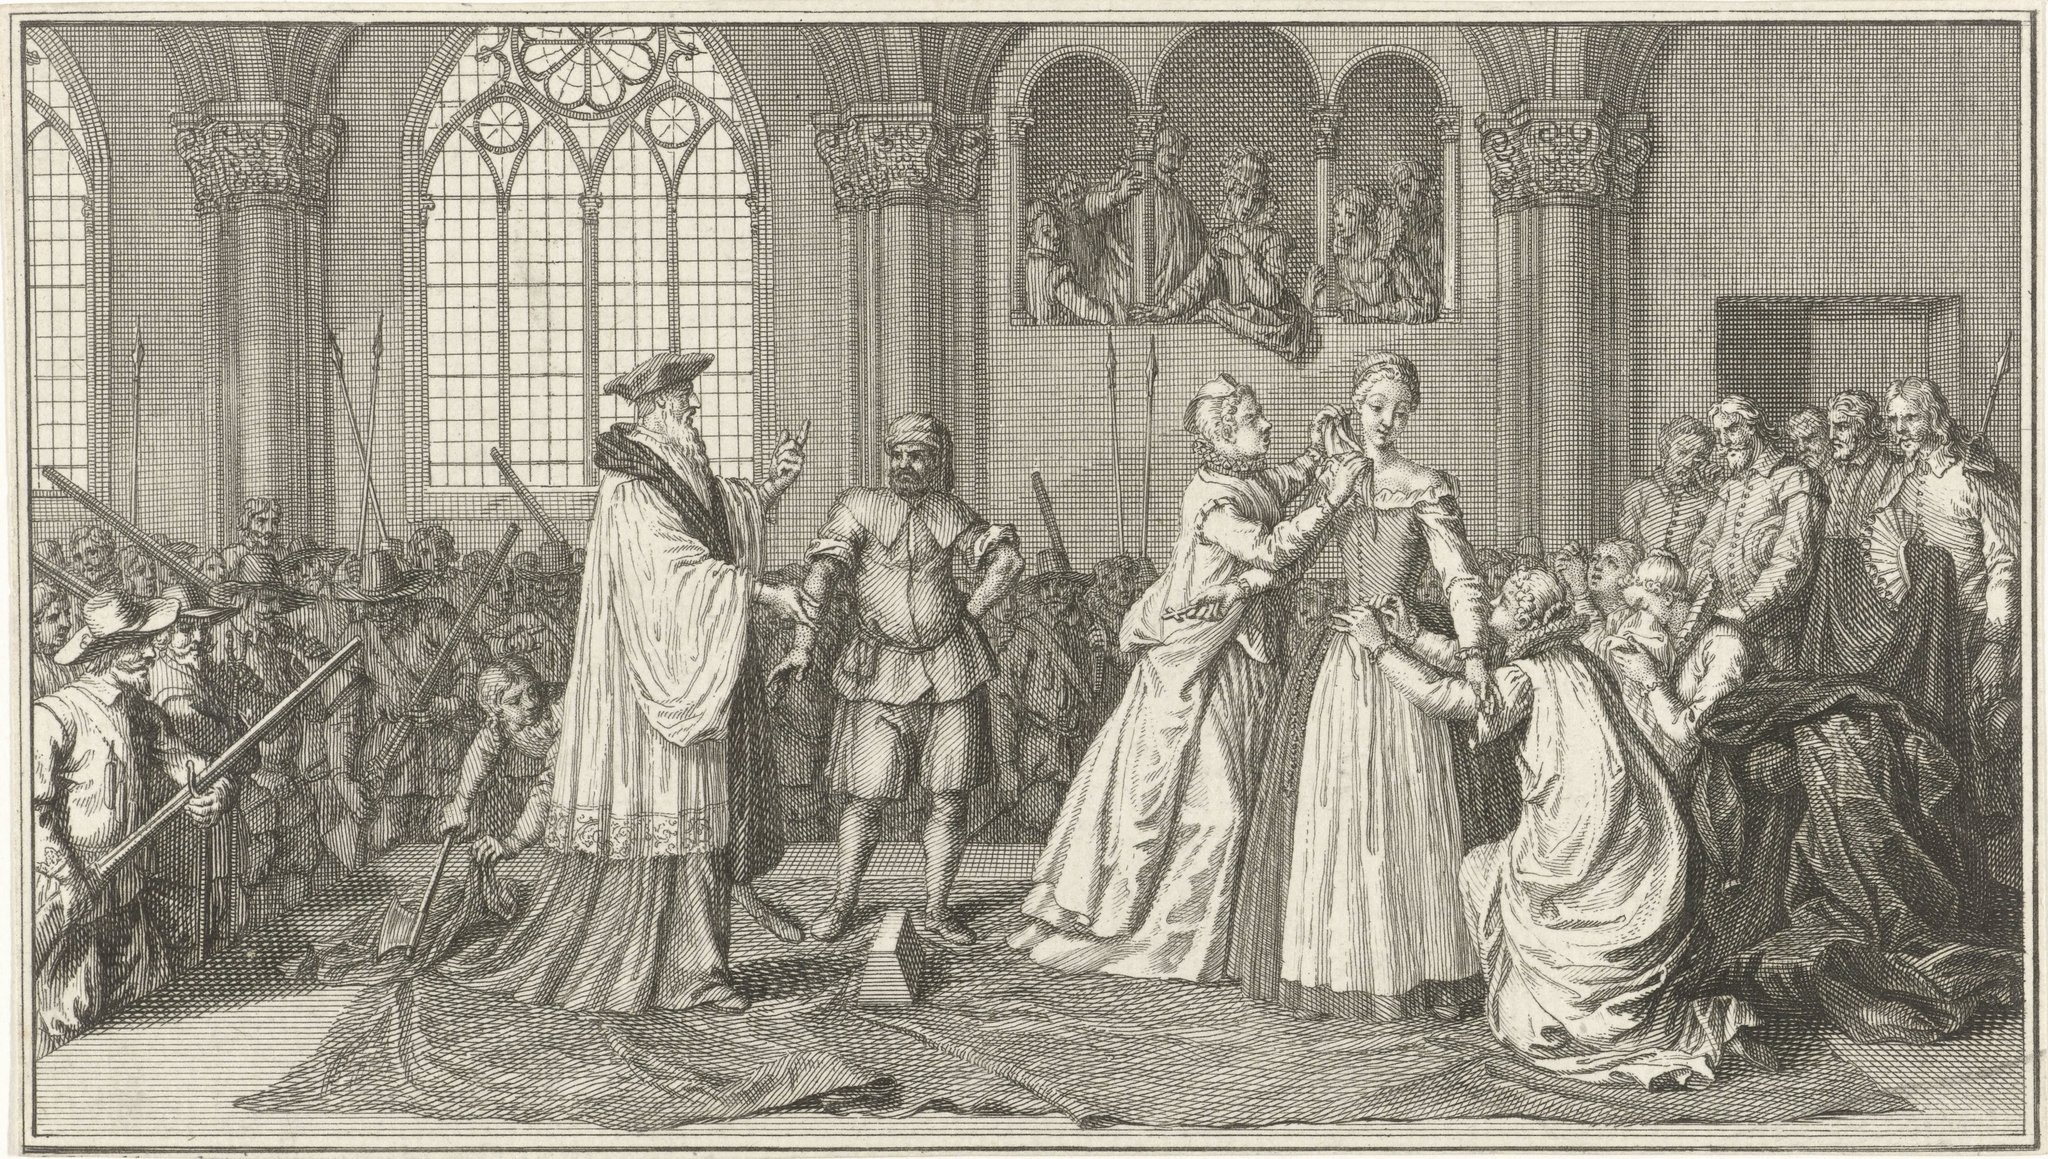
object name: print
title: Maria I Stuart wordt geblinddoekt om onthoofd te worden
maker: bernard picart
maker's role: draughtsman, print maker, publisher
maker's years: 1673-1733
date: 1729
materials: paper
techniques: engraving, etching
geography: amsterdam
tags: violent death by beheading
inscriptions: collector's mark: Lugt 240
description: Definitieve staat van deze prent ook gebruikt als illustratie in: Larrey, Isaac de. Geschiedenis van Engelandt, Schotlandt en Ierlandt, vijf delen. [Vertaald uit het Frans door] Jan Lodewyk Schuer. Amsterdam: Johannes Covens en Cornelis Mortier, 1728-1730.